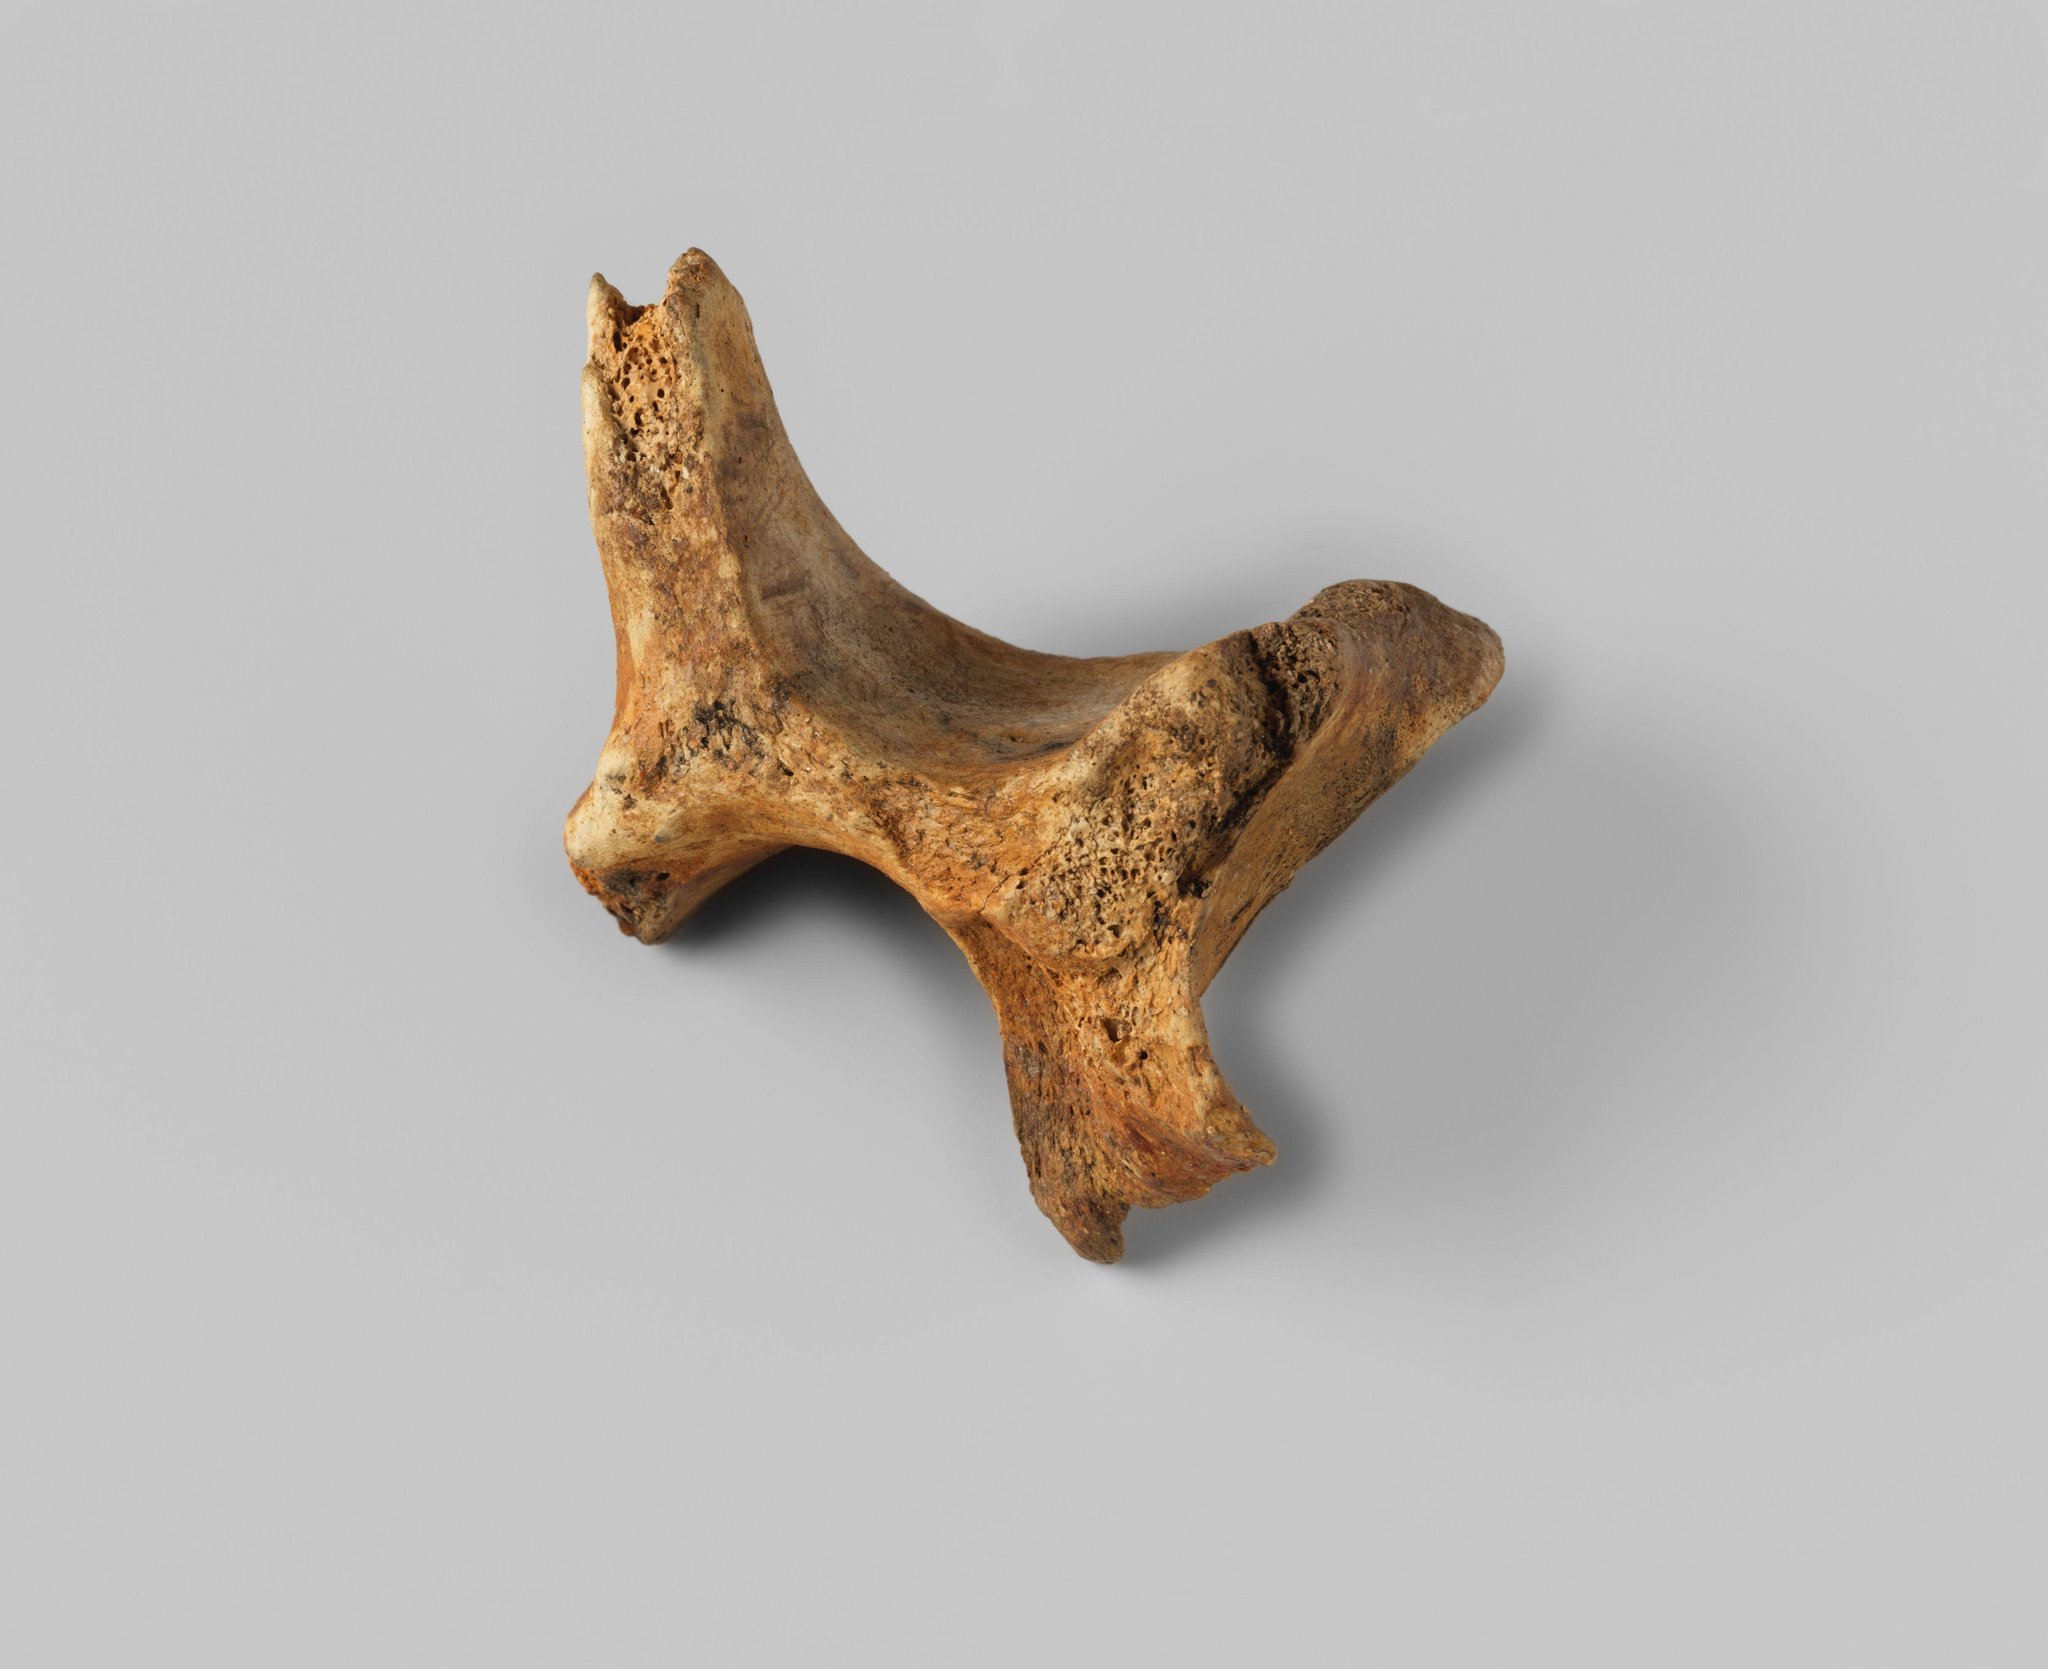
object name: bone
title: Fragment bot uit het wrak van de Oostindiëvaarder Hollandia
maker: Anonymous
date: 1700-1743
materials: bone